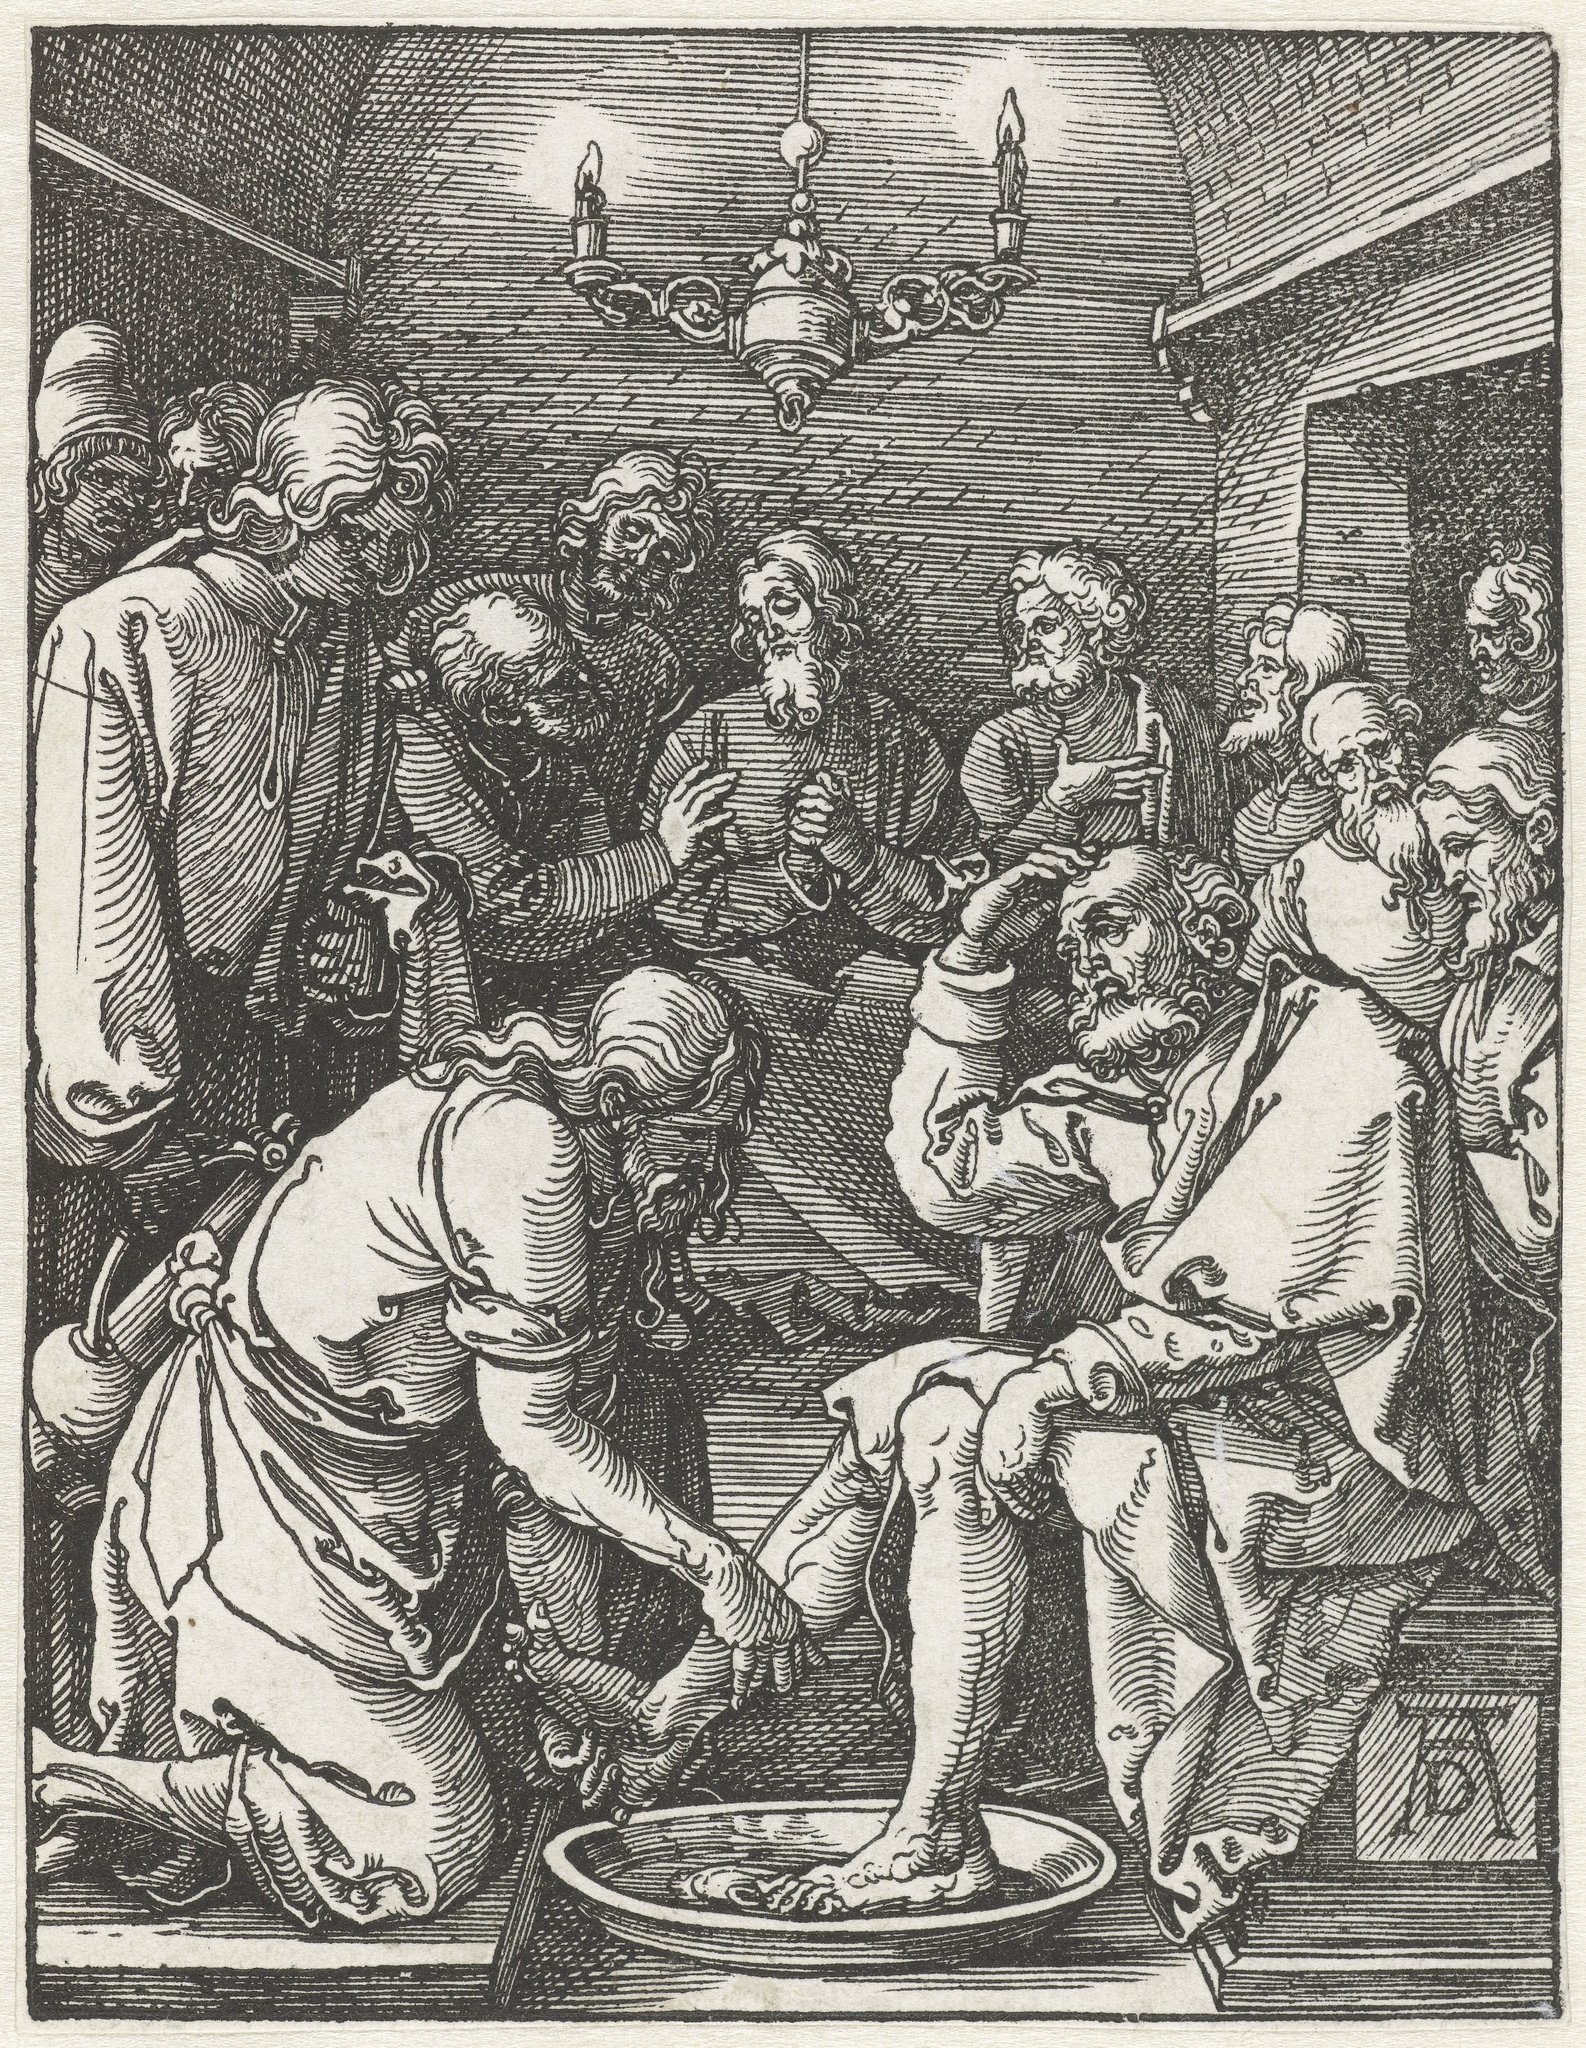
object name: print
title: De kleine Passie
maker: albrecht dürer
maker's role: draughtsman, painter, print maker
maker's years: 1471-1528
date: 1508-1509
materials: paper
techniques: woodcut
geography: nuremberg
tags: christ washes peter's feet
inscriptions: collector's mark: Lugt 2228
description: Christus wast de voeten van de discipel Petrus. De overige discipelen staan om hen heen. Deze prent is onderdeel van de prentserie 'De kleine Passie', bestaande uit een titelprent en 36 bijbelse scènes (voornamelijk uit het Lijdensverhaal).